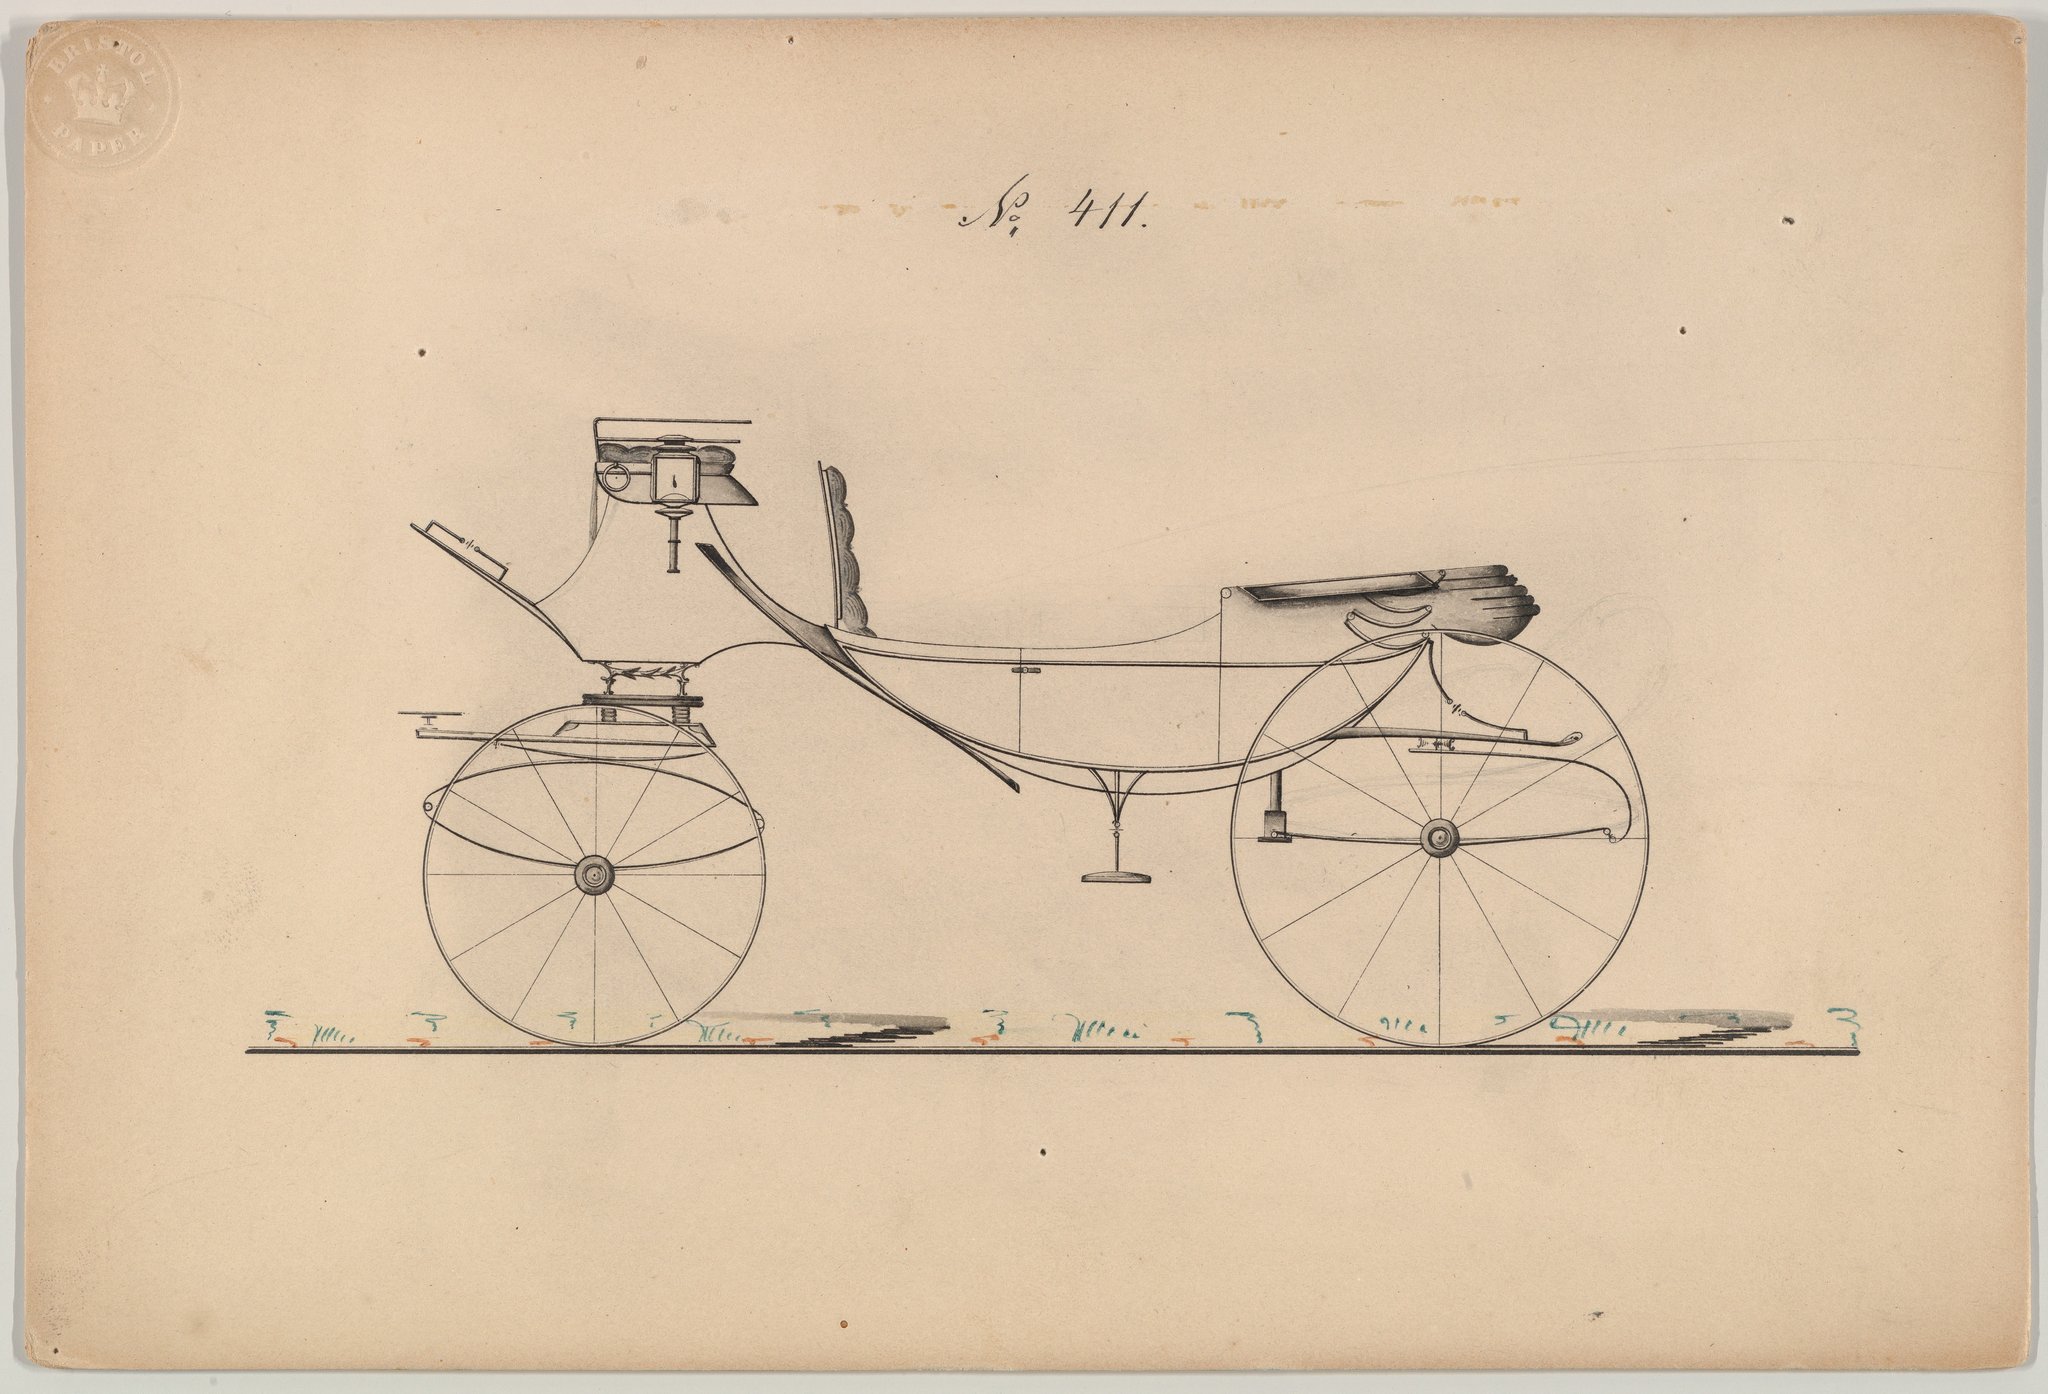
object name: drawing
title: Design for Vis-à-vis, no. 411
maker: brewster & co.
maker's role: manufacturer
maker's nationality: american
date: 1850-1870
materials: ink, watercolor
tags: carriages